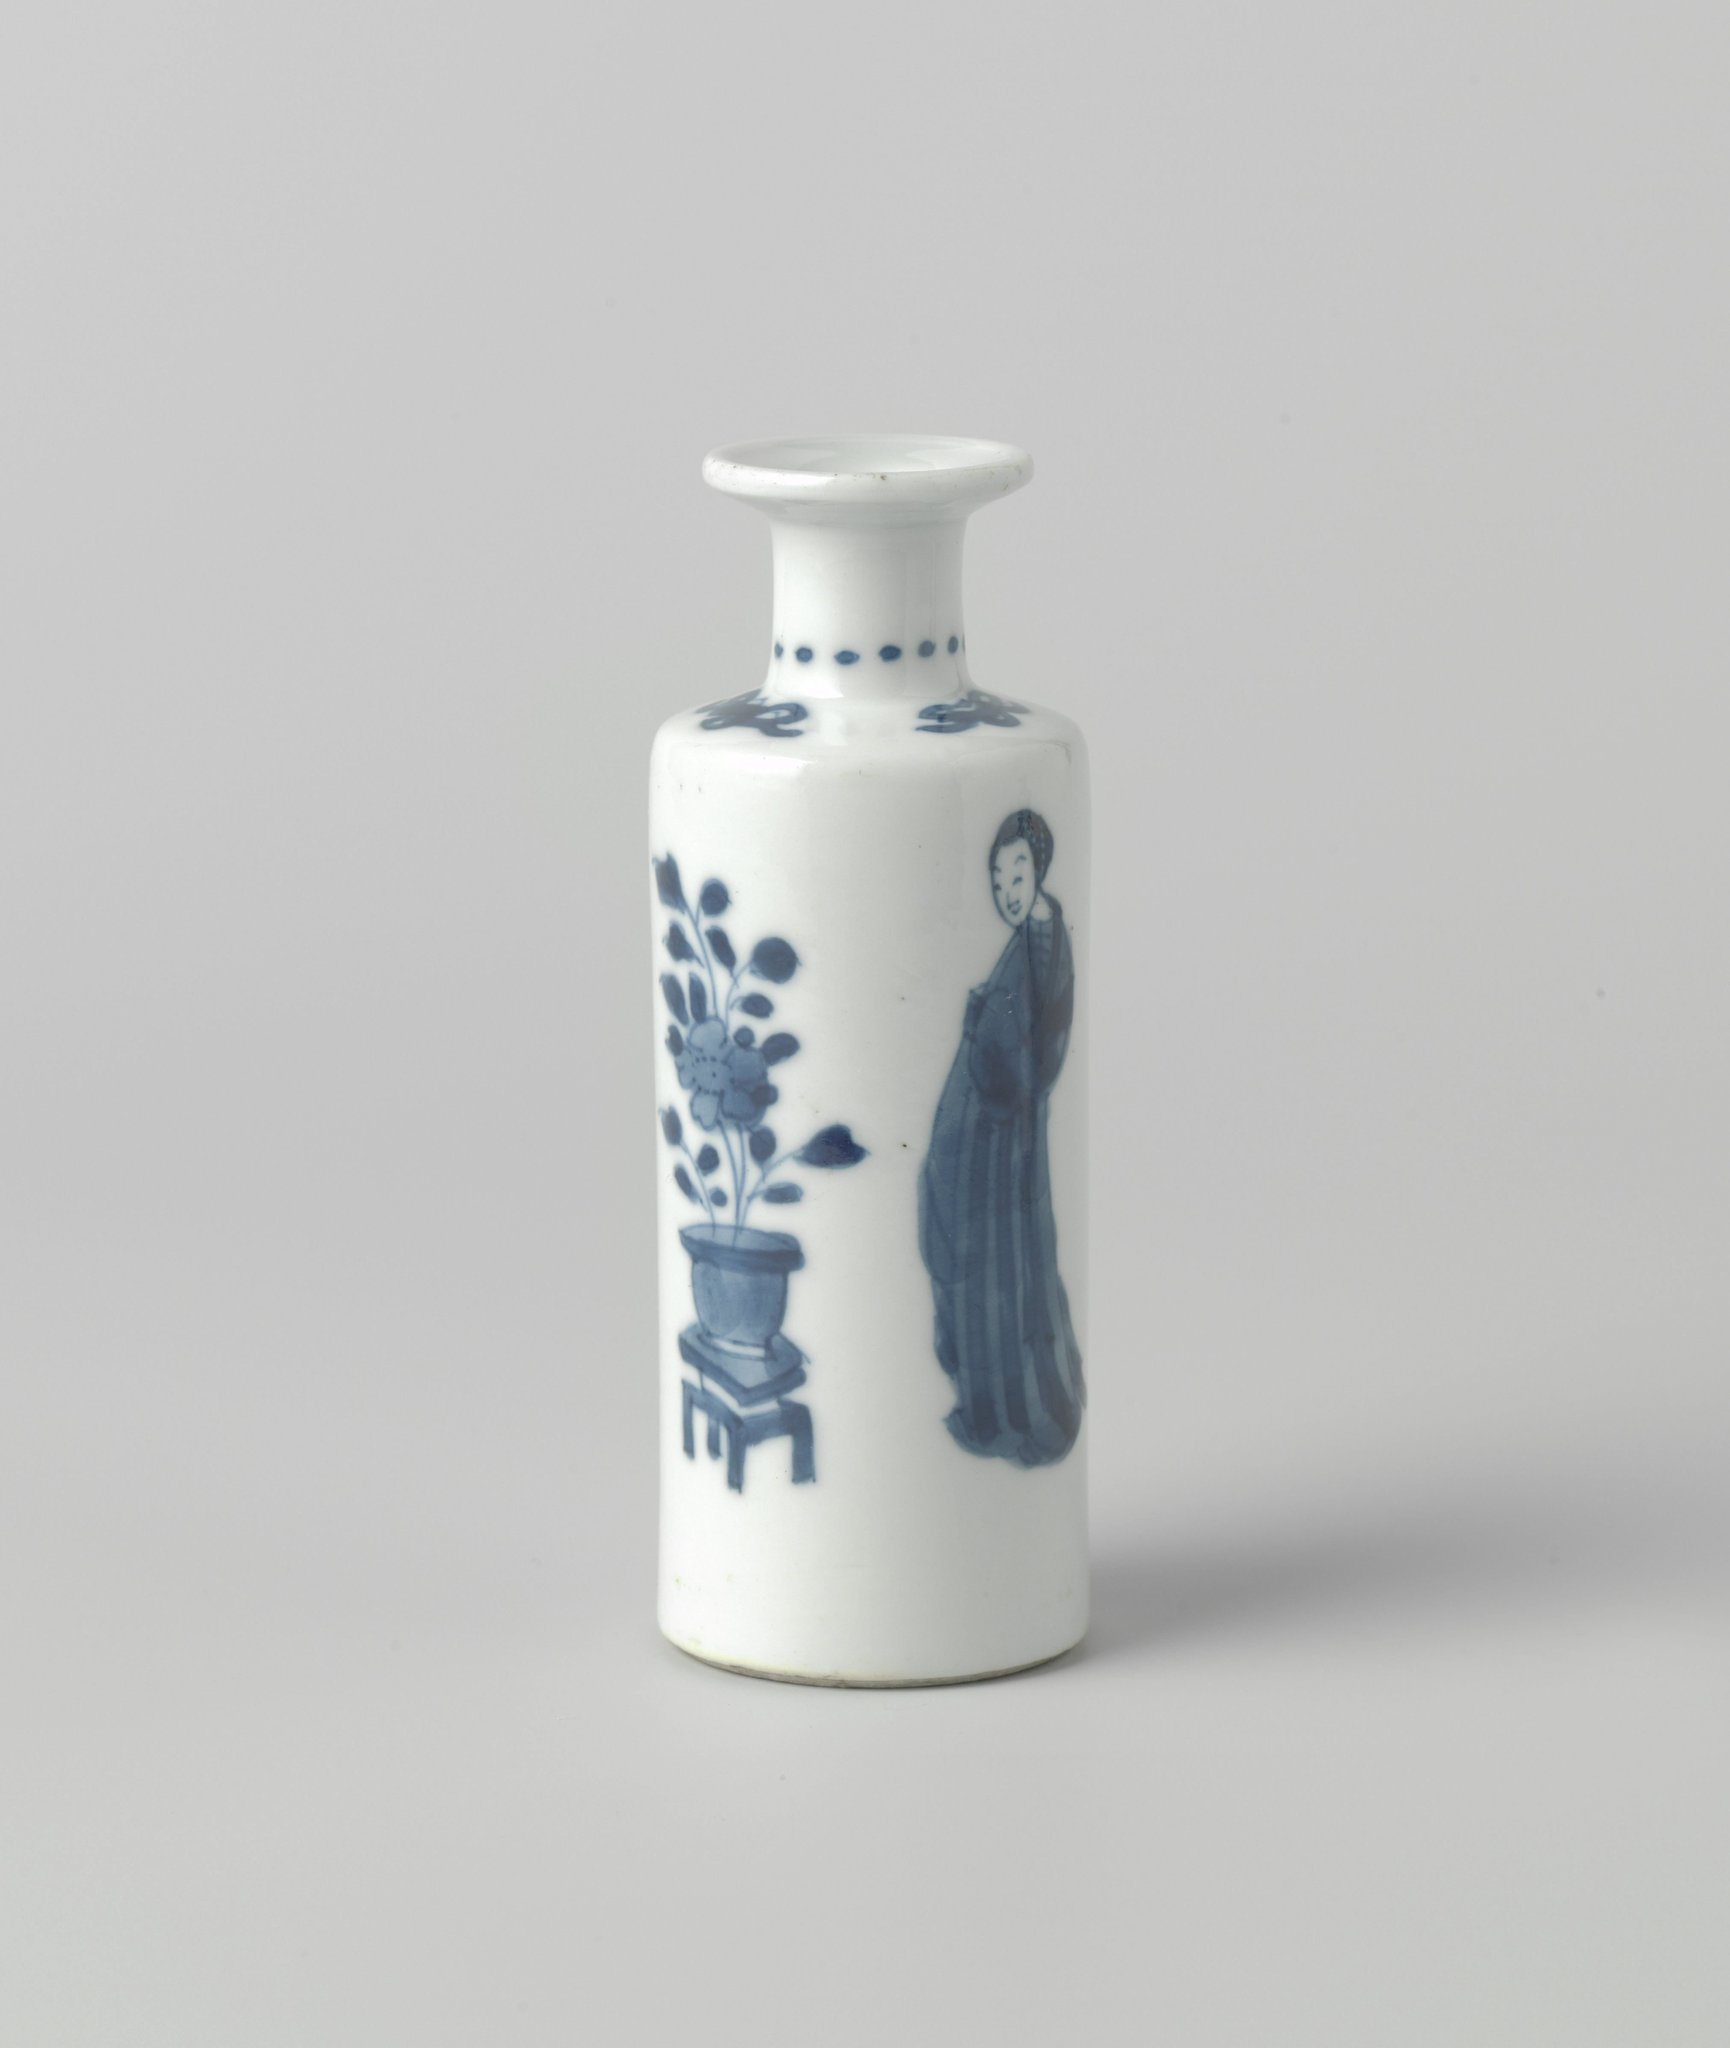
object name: vase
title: Cilindrical vase with women and flower pots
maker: Anonymous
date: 1680-1720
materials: cobalt, glaze, paint, porcelain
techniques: firing, turning, vitrification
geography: china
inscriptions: mark: ‘Fú’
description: AK-NM-6723 Twee kleine vazen • Blauw-wit Kangxi-porselein • Onderdeel van Royers porseleincollectie Deze kleine vaasjes waren net als de dekselpotjes (AK-NM-6927 en 6928) geliefd als etagère goed. Er is geopperd dat dit een Chinese vorm is, de rouleau-vaas die in de Kangxi-periode is voortgekomen uit de rolwagen, en in dit geval dus heel klein is uitgevoerd [Cheng 2009, nrs. 36 en 37]. Problematisch vind ik dat de rouleau-vaas naar beneden toe iets versmalt en op een smallere standring staat. Ik vind de vorm ook erg Europees, denk aan Romeins glas. Houten modellen waren geliefd om vorm-wensen over te brengen. Het kost me grote moeite om een dergelijk flesje níet in gedraaid hout voor te stellen. Zekerheid ontbreekt natuurlijk. De voorstelling is een goed voorbeeld van ‘lijzen’, elegante vrouwfiguren die zonder context tegen een witte achtergrond zijn geplaatst. In de Overgangsperiode zijn vrouwen op porselein gangbaar als onderdeel van een verhalende scène, en voor een deel wordt dat voortgezet in de Kangxi-tijd (zie AK-NM-6928). Voor het ontstaan van de ‘losse’ lijzen is gewezen op een keizerlijk besluit uit 1652 [Campbell 2022]. Onzedelijke literatuur, waaronder veel geïllustreerde romans werden verboden. Hierdoor nam de productie van geïllustreerde boeken af. Het schilderen van vrouwen op porselein – zeker uit hun context gelicht – was wél mogelijk en hiervoor werd dus vaker gekozen, ten koste van de verhalende voorstellingen. Een andere verklaring voor de opkomst van de lijzen, is dat het makkelijker en sneller was. Europese kopers snapten het verhaal toch niet en kregen gaandeweg een voorkeur voor wat rustiger gedecoreerd porselein. Voor dit deel van de markt konden de porseleinschilders dus volstaan met de eenvoudiger en dus voordeliger lijzen-beschildering. Ook de pot met bloeiende planten kan gezien worden als een vereenvoudigde versie van een bekend element. Op Royers dekselpot uit de Overgangsperiode (AK-NM-6775) komen ze ook voor, met veel zorg geschilderd om tegemoet te komen aan de hoge eisen en verwachtingen van Chinese kopers. Hier is sprake van een aantrekkelijke maar snel geschilderd beeldelement. Nog steeds aantrekkelijk, zeker als het vaasje onderdeel uitmaakte van een grote opstelling. Royer had behalve dit paar nog drie vrijwel identieke exemplaren (AK-NM-6724-A en -B, AK-NM-6726). Vergelijkbare vaasjes komen voor in vele collecties, waaronder een bekende Nederlandse collectie die aan het begin van de 20ste eeuw werd samengesteld door B.J.V. van Hees (1873-1953). Zijn kleinzoon, Henk Nieuwenhuys, schonk een deel daarvan aan het Shanghai Museum [Cheng 2009, nrs. 36 en 37]. Bronnen: Cheng Xiejun (red.), Traces of the trade: Chinese export porcelain donated by Henk B. Nieuwenhuys (tent.cat. Shanghai Museum), Shanghai, 2009. Denise campbell, ‘Meer dan schoonheid. De weergave van vrouwen op Chinees porselein’, Aziatische Kunst 52/2 (2022), pp. 50-57.